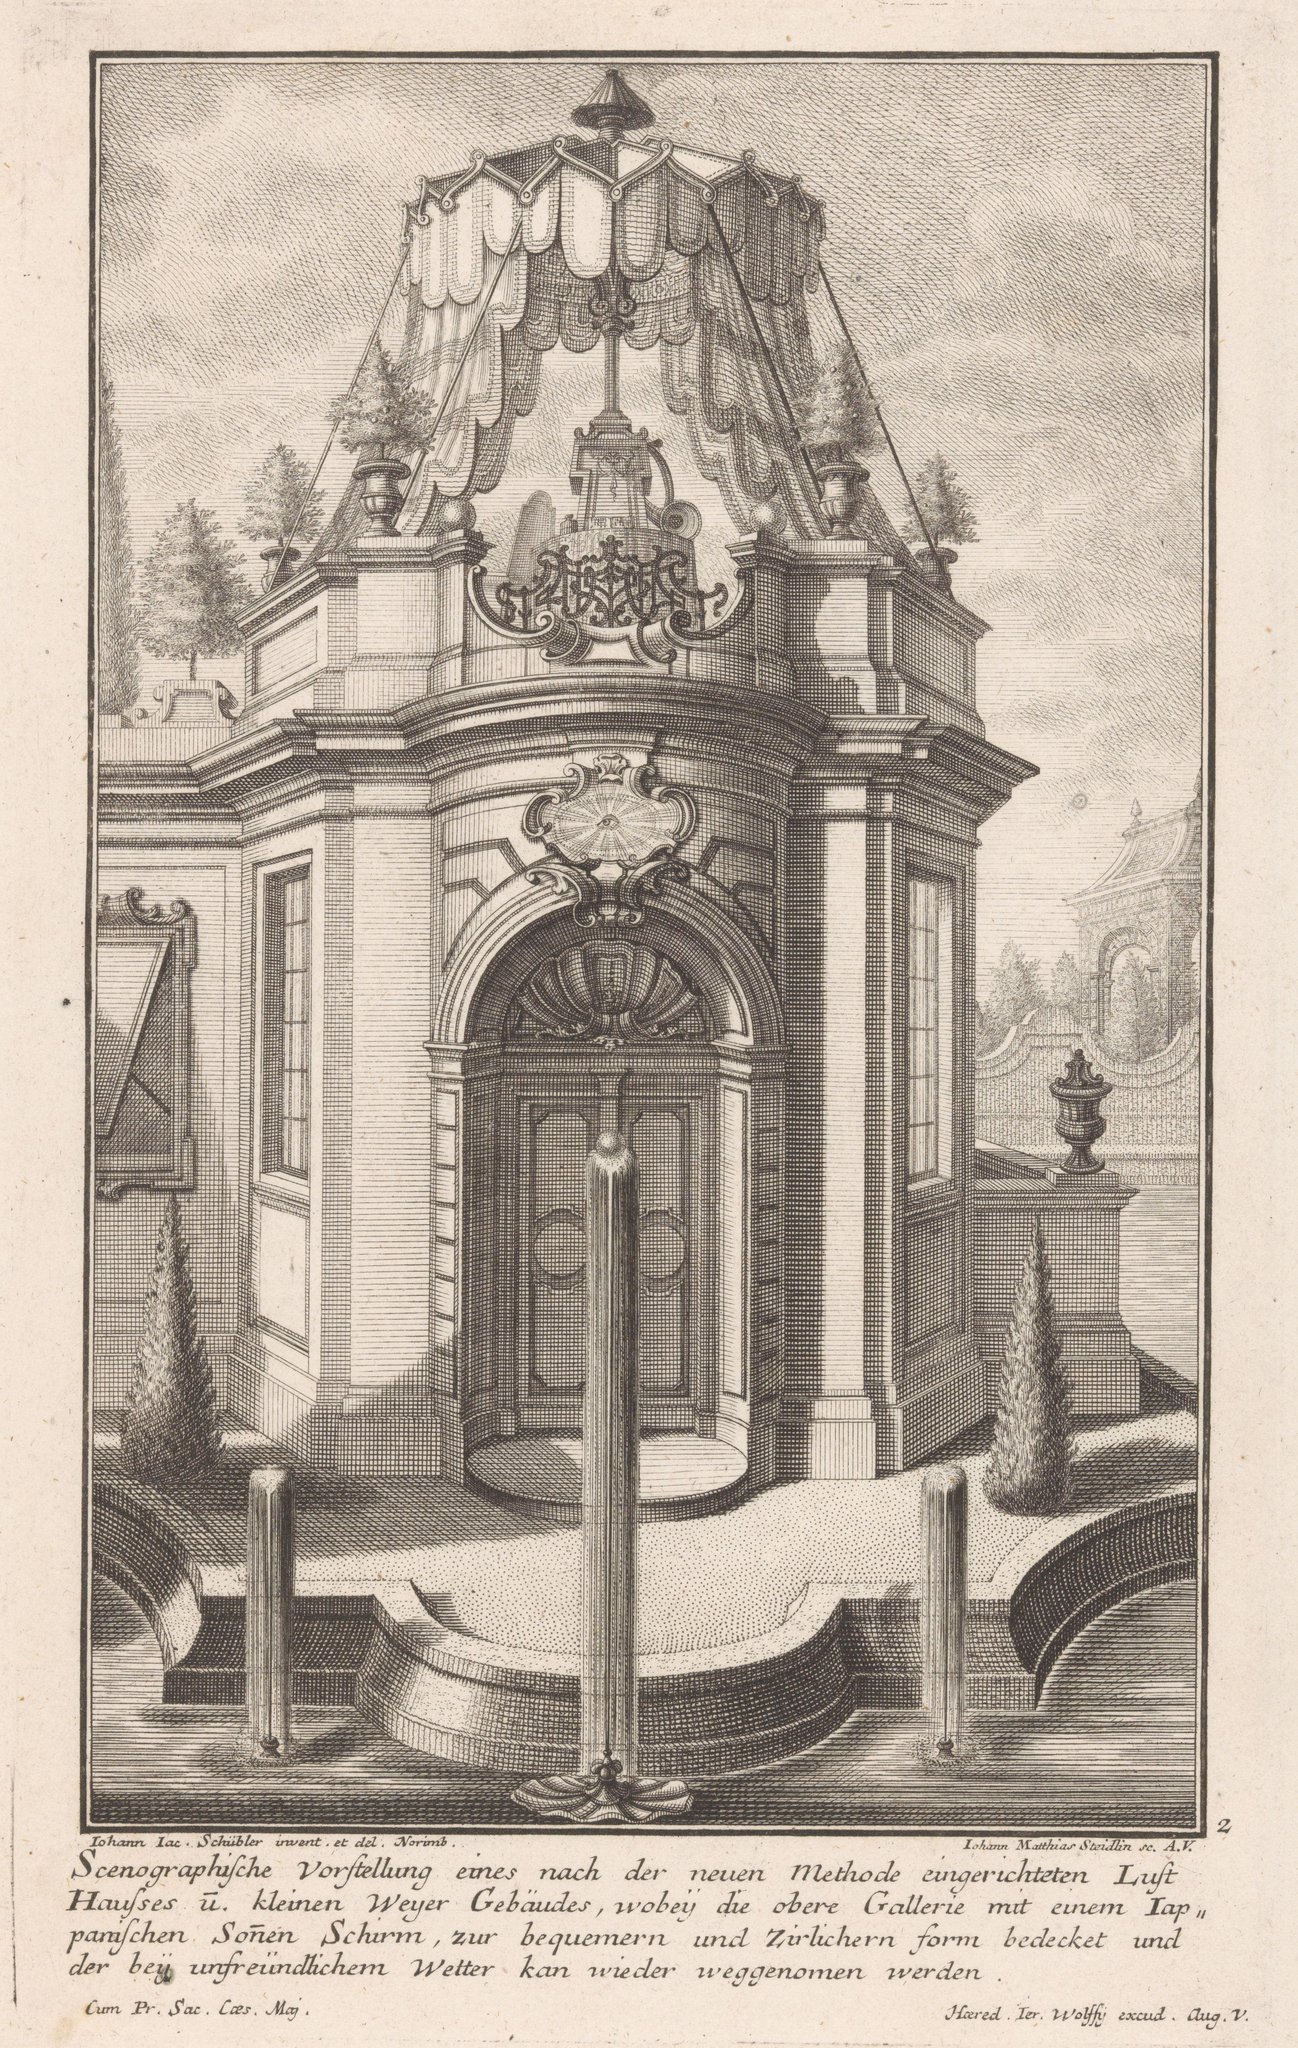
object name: print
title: Johann Jacob Schüblers Siebende Ausgabe seines vorhabenden Wercks, Worinnen vorgestellet werden Neu-inventierte Sommer-Häuser, Garten-Cabinetten (...)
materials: paper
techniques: engraving, etching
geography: augsburg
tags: garden fountain, summer-house, arbour, garden-house (dutch: 'theekoepel'), sunblind, sunshade, awning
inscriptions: collector's mark: Lugt 2228, collector's mark: Lugt 2760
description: Een geornamenteerd tuinhuis met cartouche met het alziend oog en een Japans zonnescherm. Rechts en aan de voorzijde wordt het huis omgeven door water en fonteinen. In de ondermarge een vierregelige Duitse tekst.